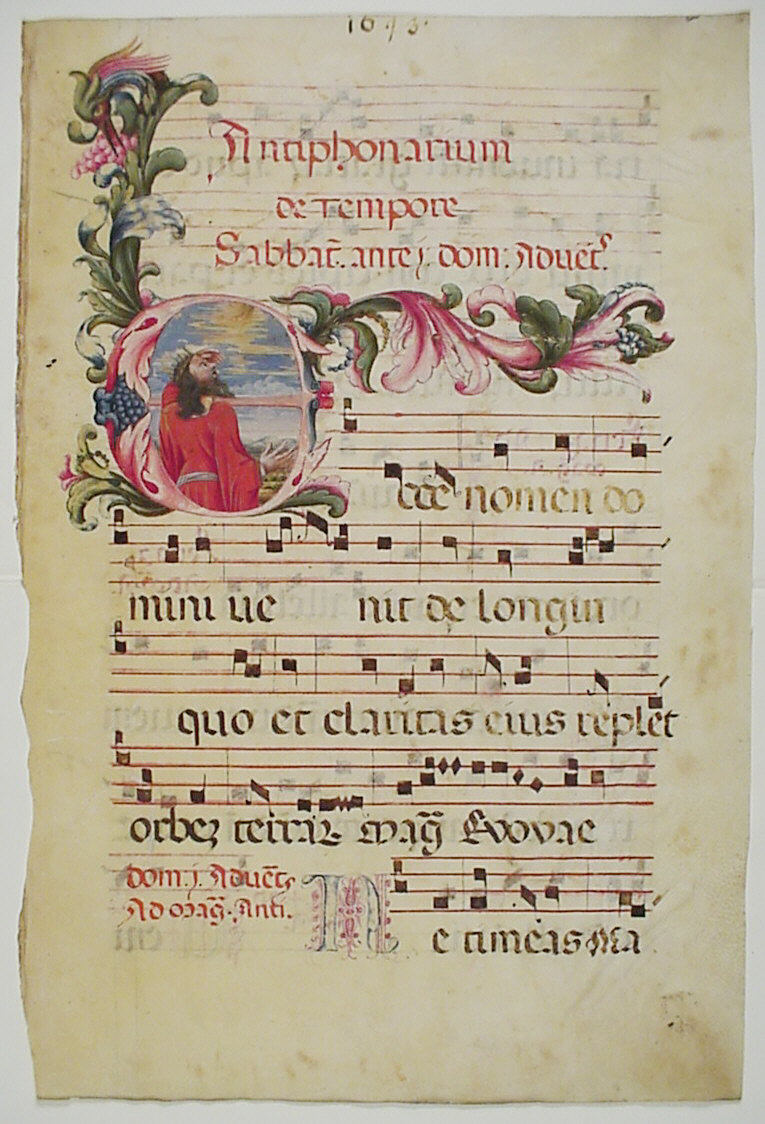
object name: antiphonary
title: Manuscript Leaf with Initial E, from an Antiphonary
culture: italian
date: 1501-1600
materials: ink, parchment, paint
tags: men,profiles,music